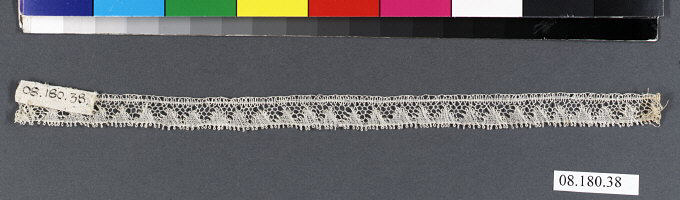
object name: edging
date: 1701-1800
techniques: lace